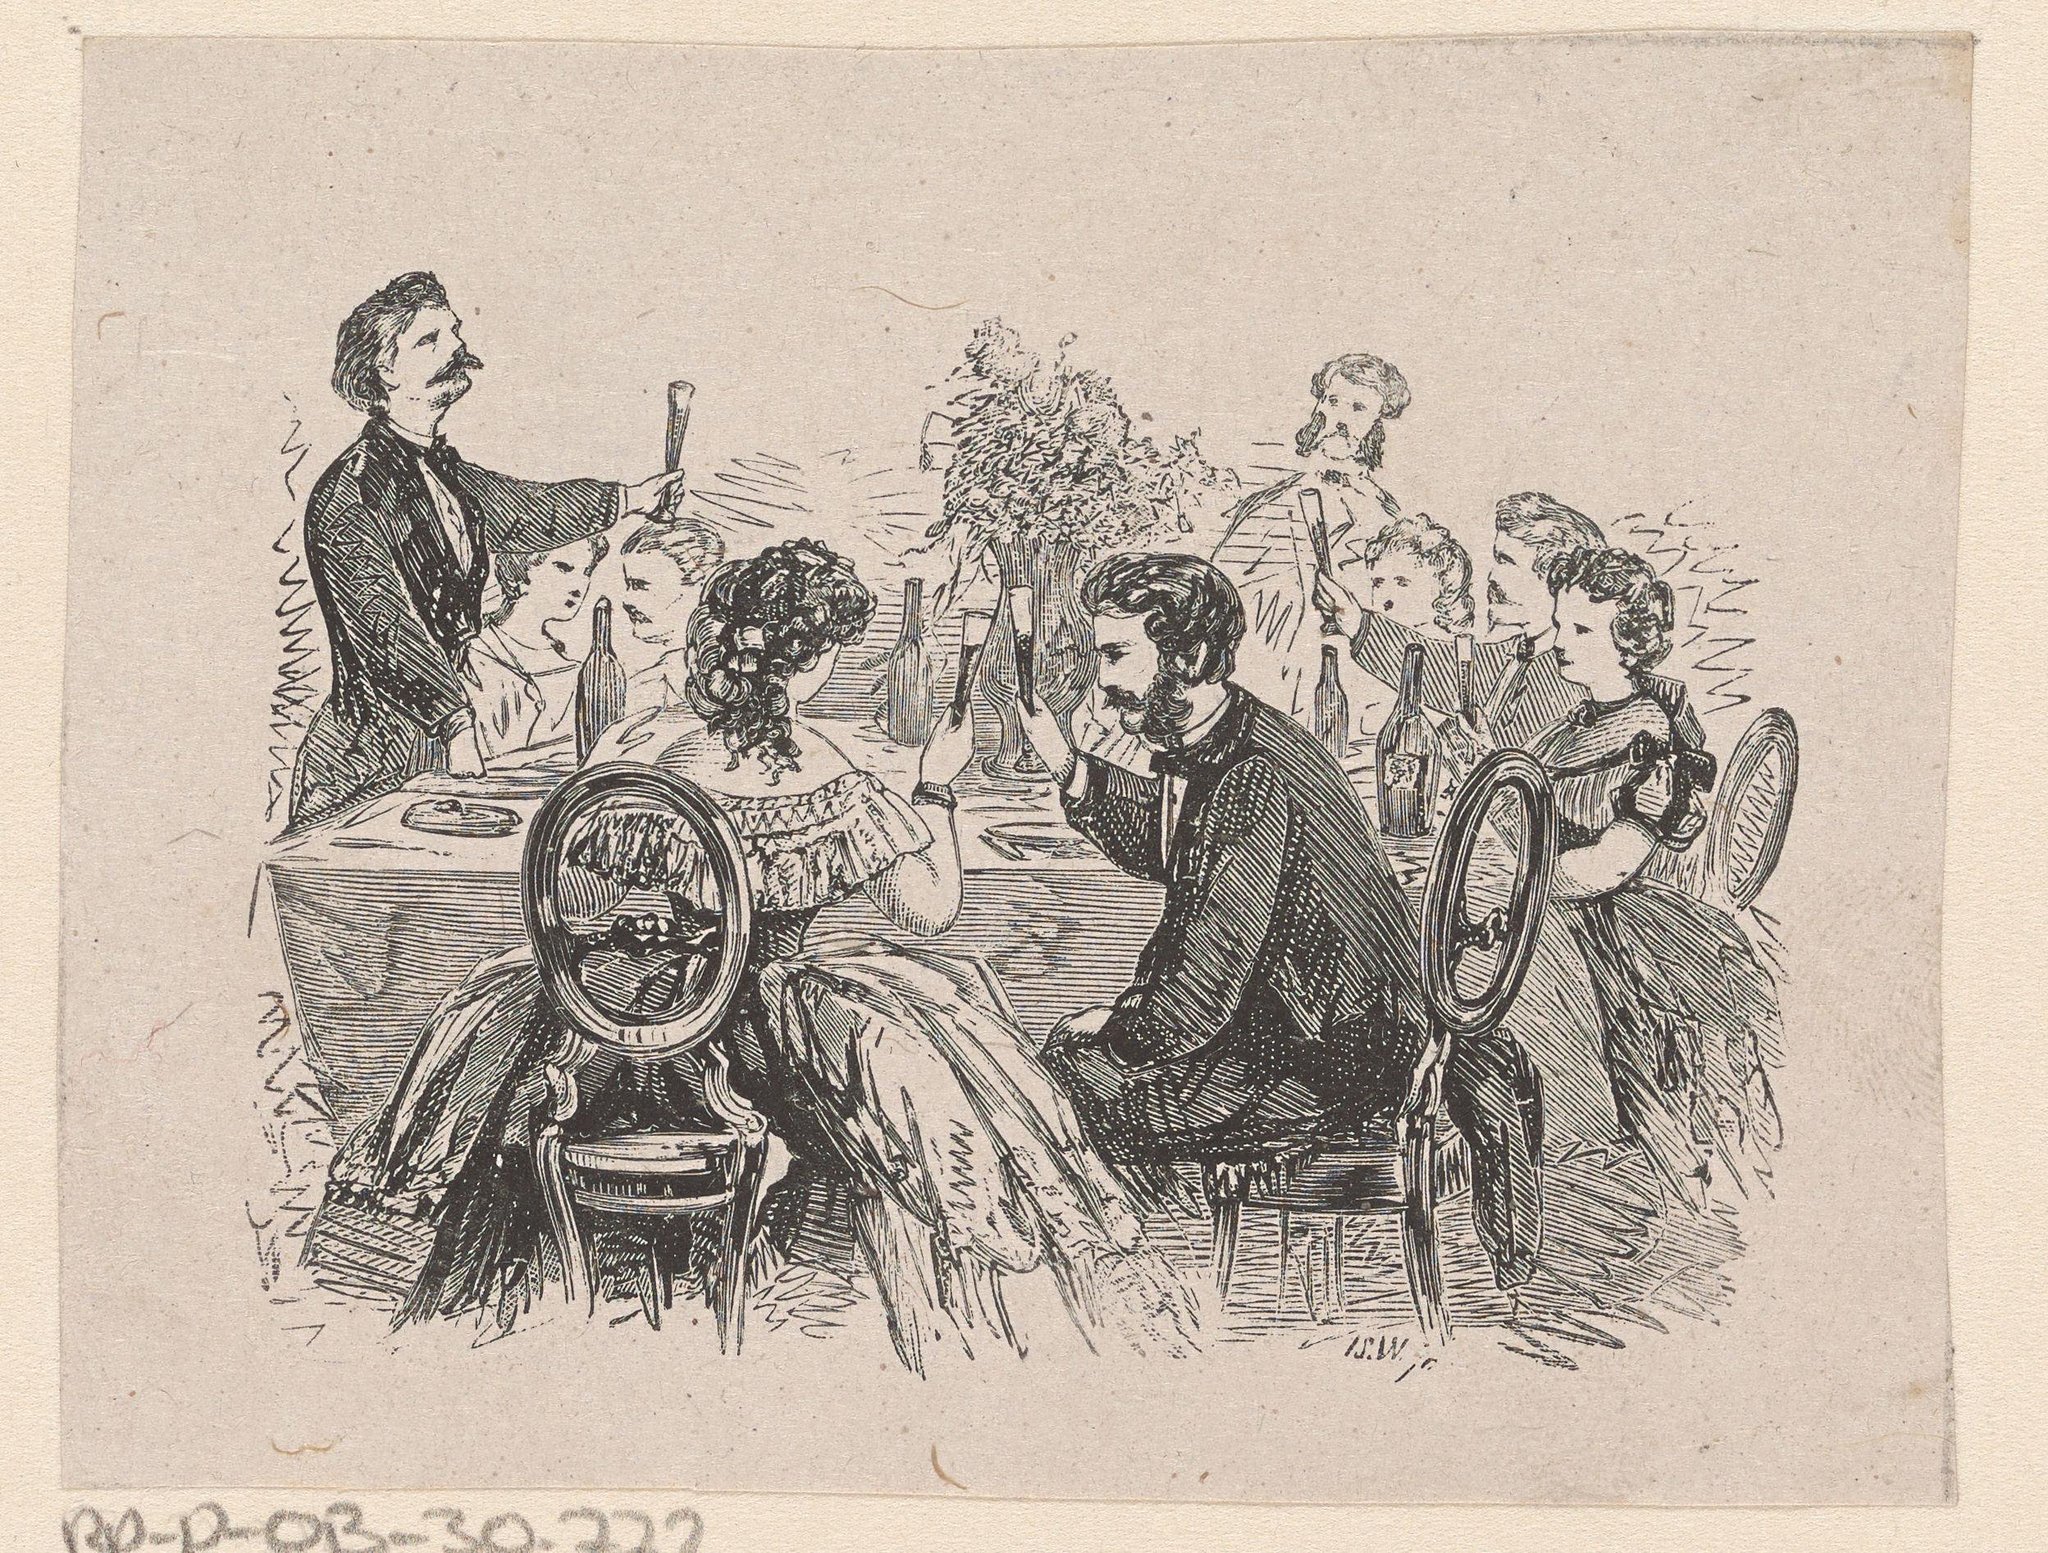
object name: print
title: Gezelschap rondom een tafel met elkaar proostend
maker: isaac weissenbruch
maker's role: print maker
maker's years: 1826-1912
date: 1836-1912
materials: paper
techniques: engraving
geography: netherlands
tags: adult woman, adult man, drinking